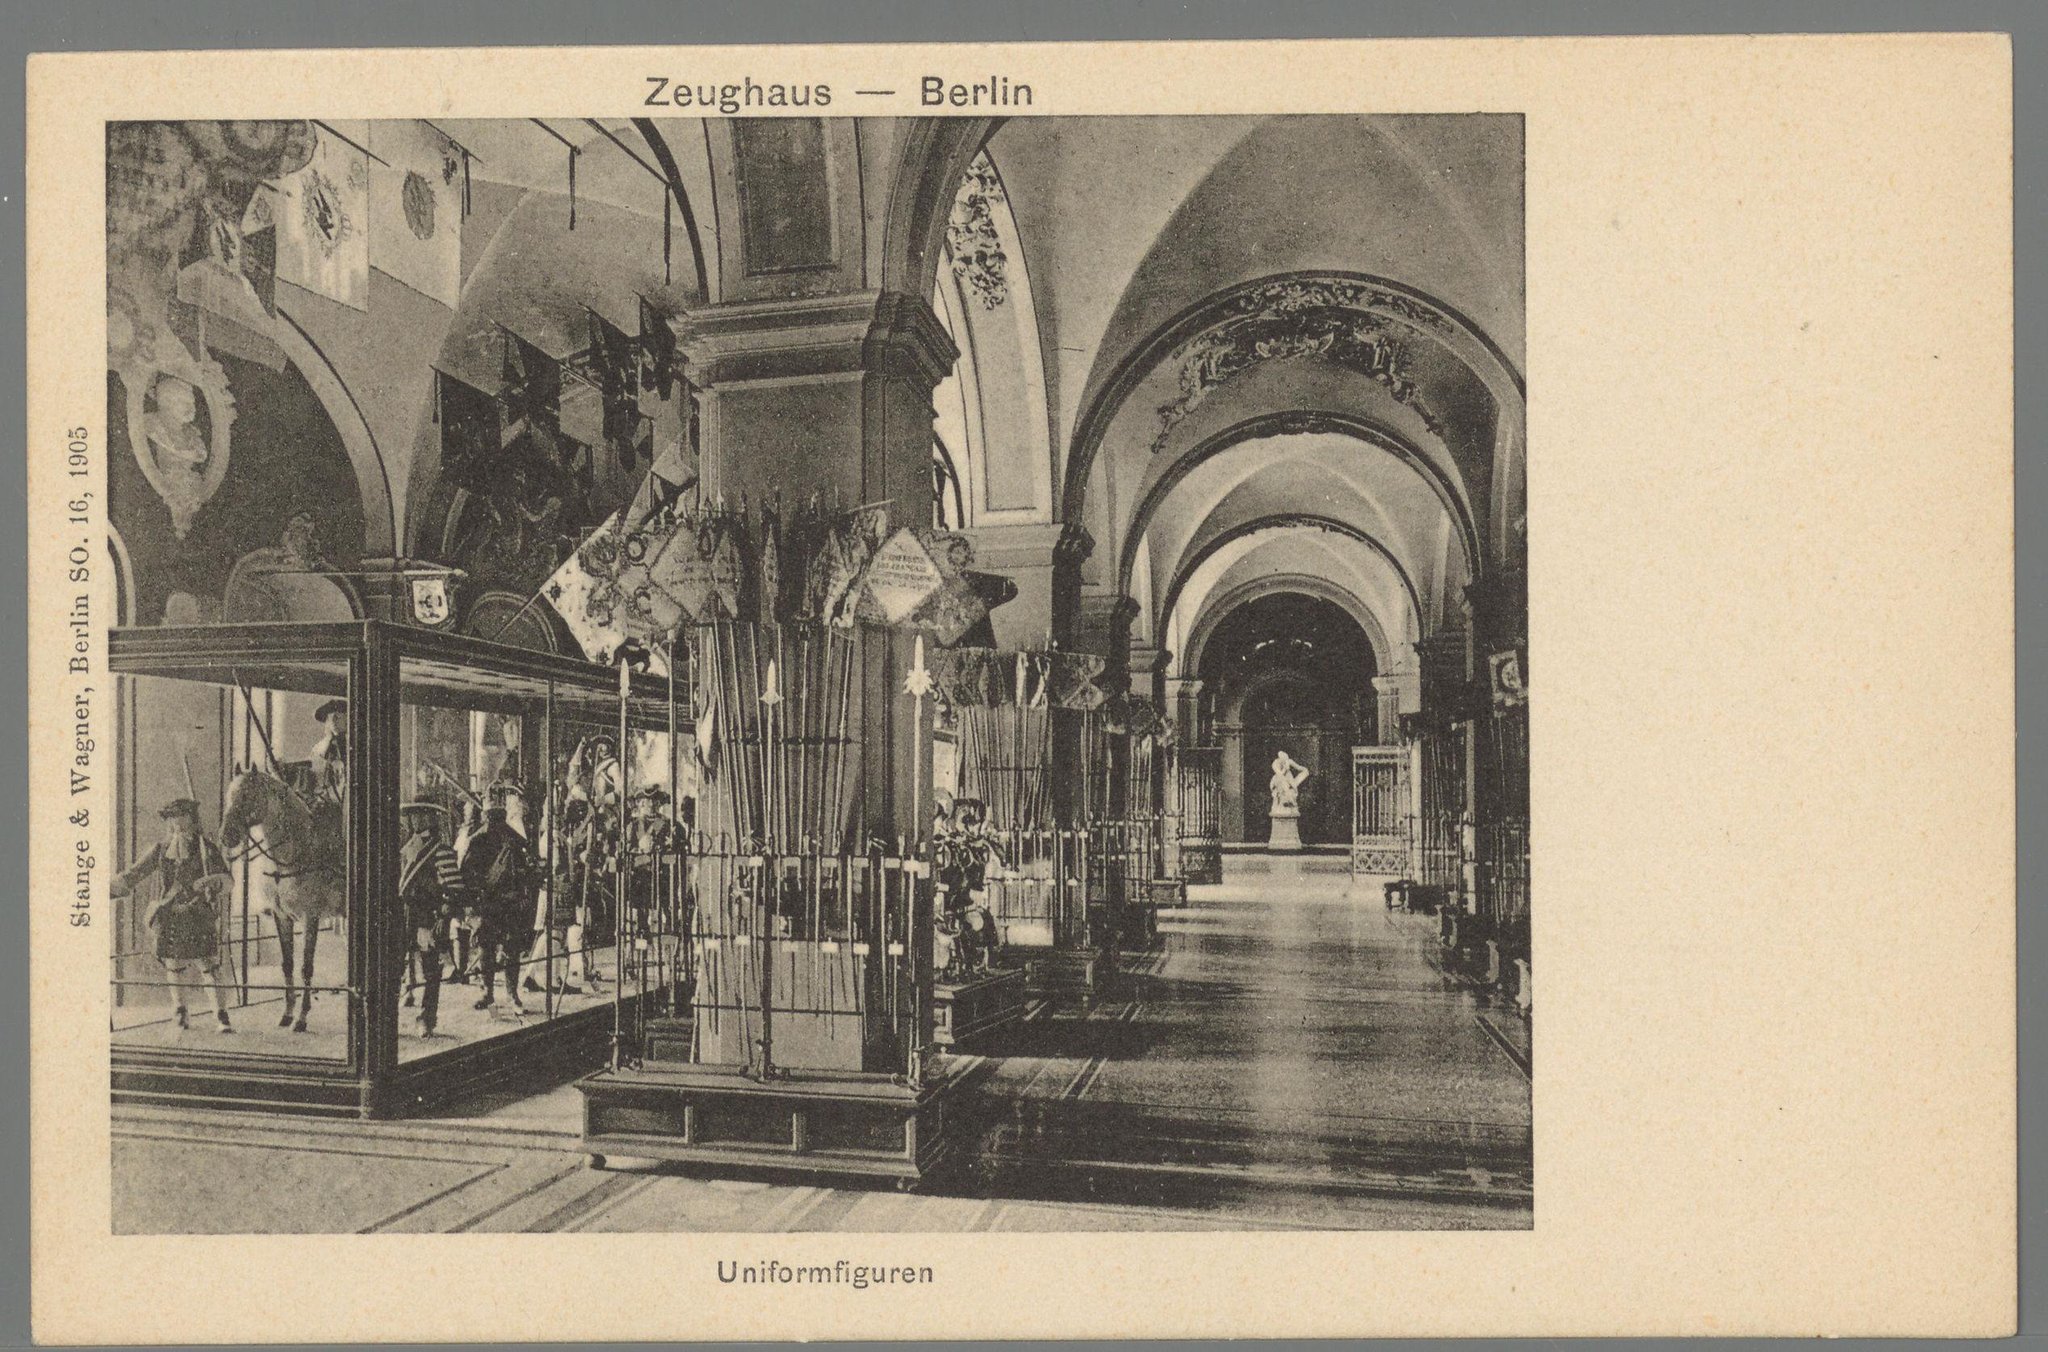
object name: photomechanical print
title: Zeughaus - Berlin. Uniformfiguren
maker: Anonymous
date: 1905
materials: cardboard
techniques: photograph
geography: berlin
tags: permanent exhibition, museum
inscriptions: date